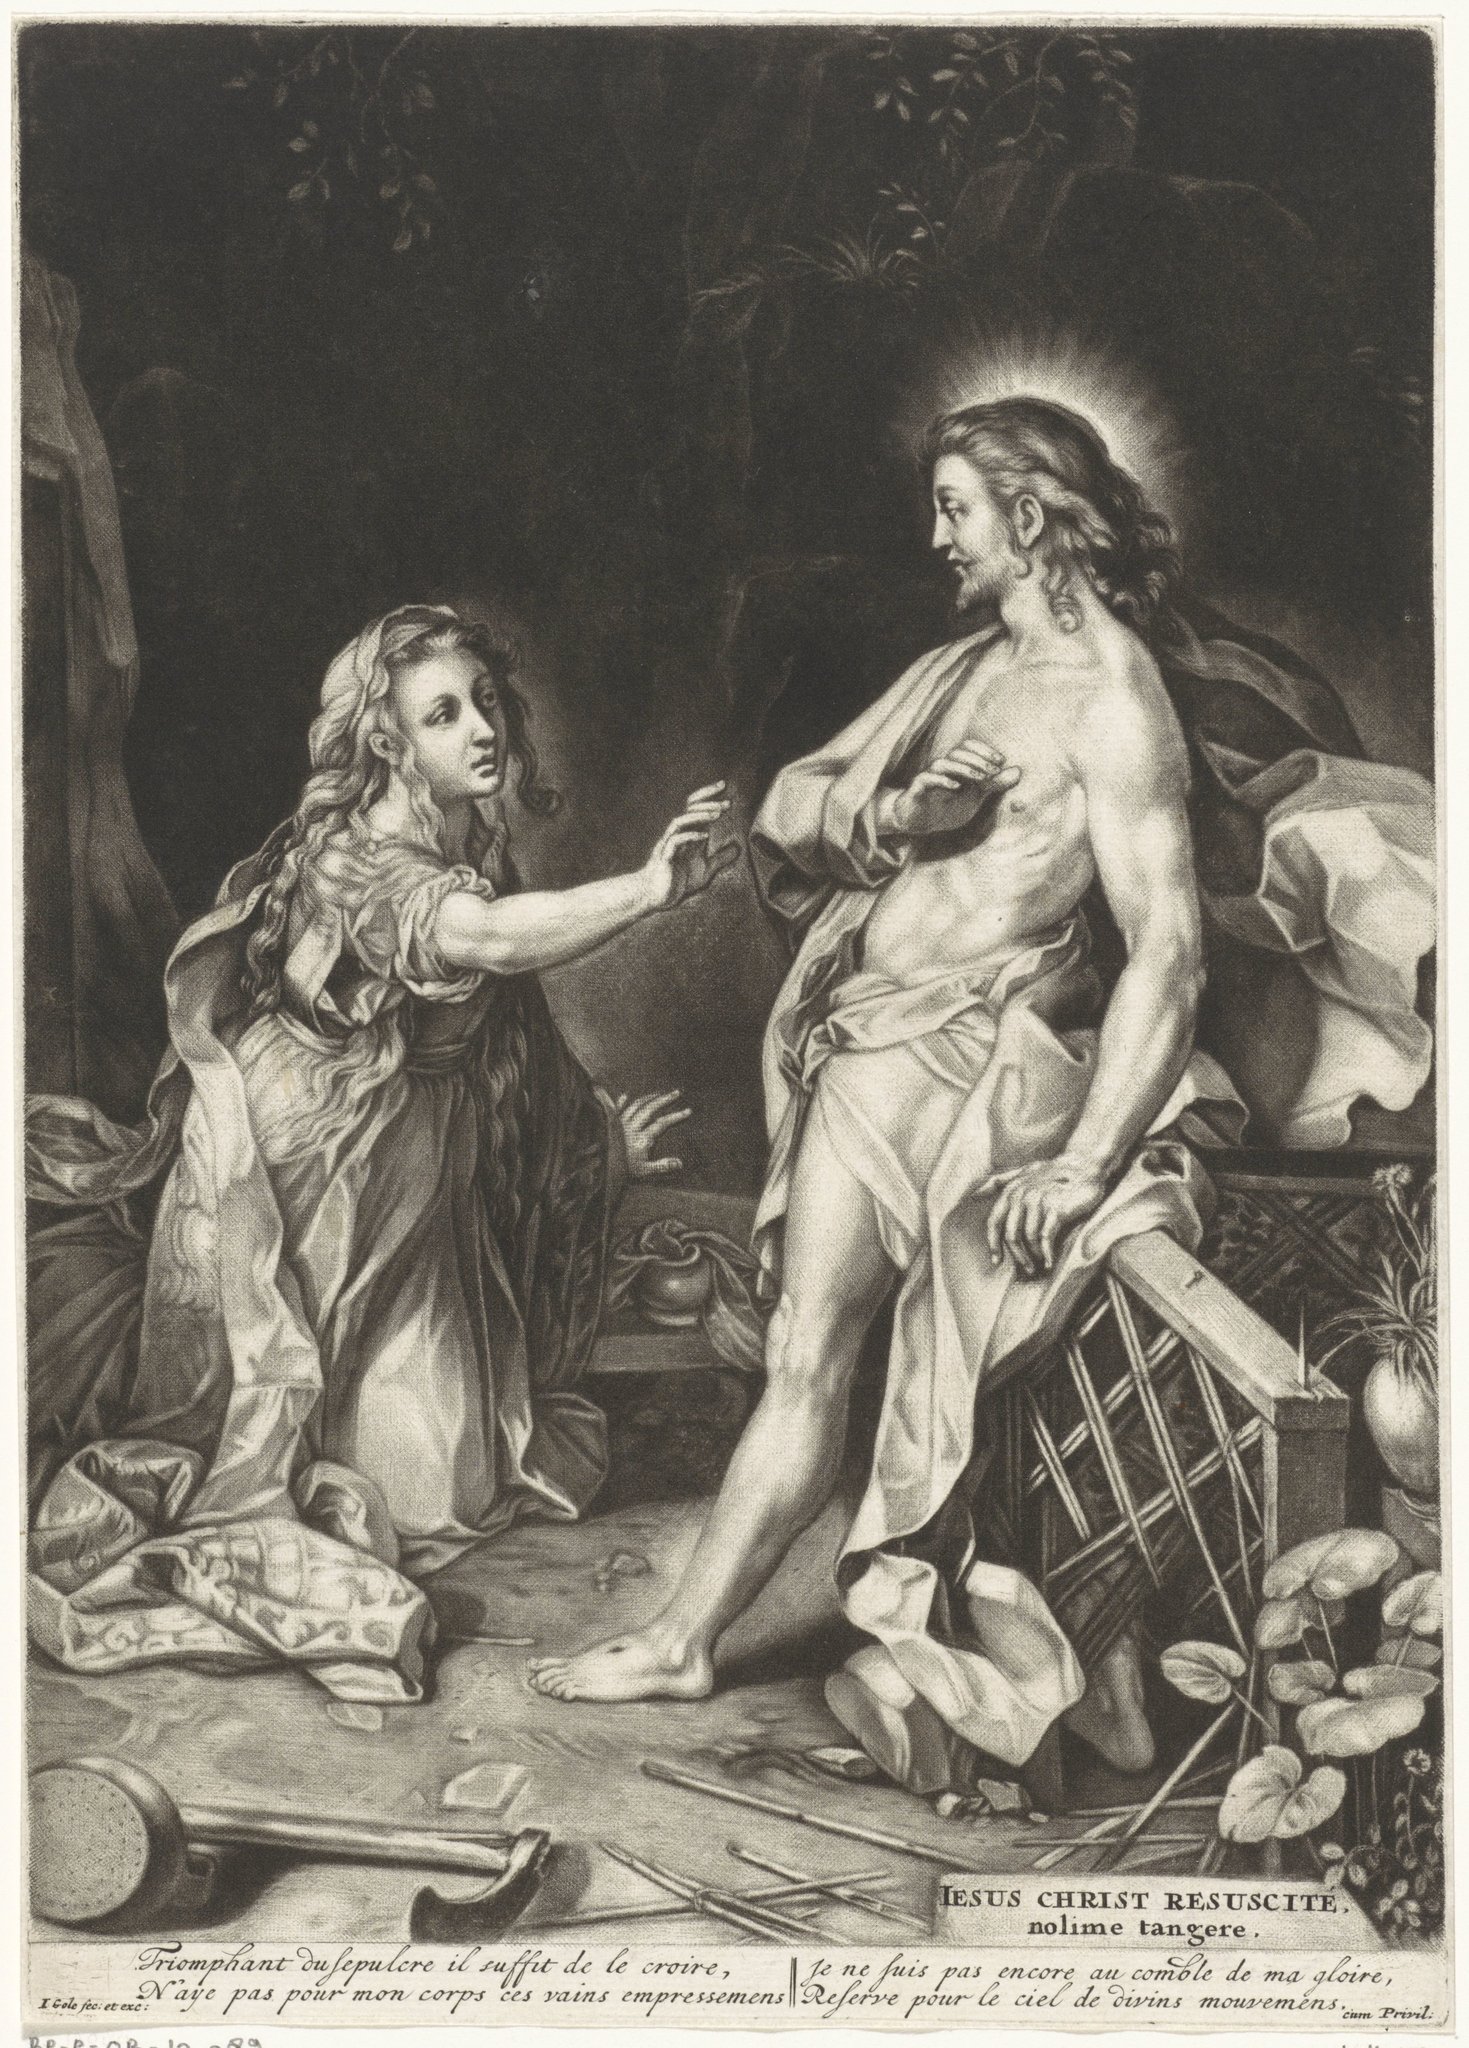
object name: print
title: Iesus Christ Resuscité, nolime tangere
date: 1670-1724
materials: paper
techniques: engraving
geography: amsterdam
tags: mary magdalene kneeling before christ, who is usually represented as a gardener with a hoe and/or a spade; 'noli me tangere'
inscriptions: collector's mark: Lugt 240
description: Christus verschijnt aan Maria Magdalena in de tuin. Zij knielt voor hem en reikt naar hem. Naast haar de zalfpot.